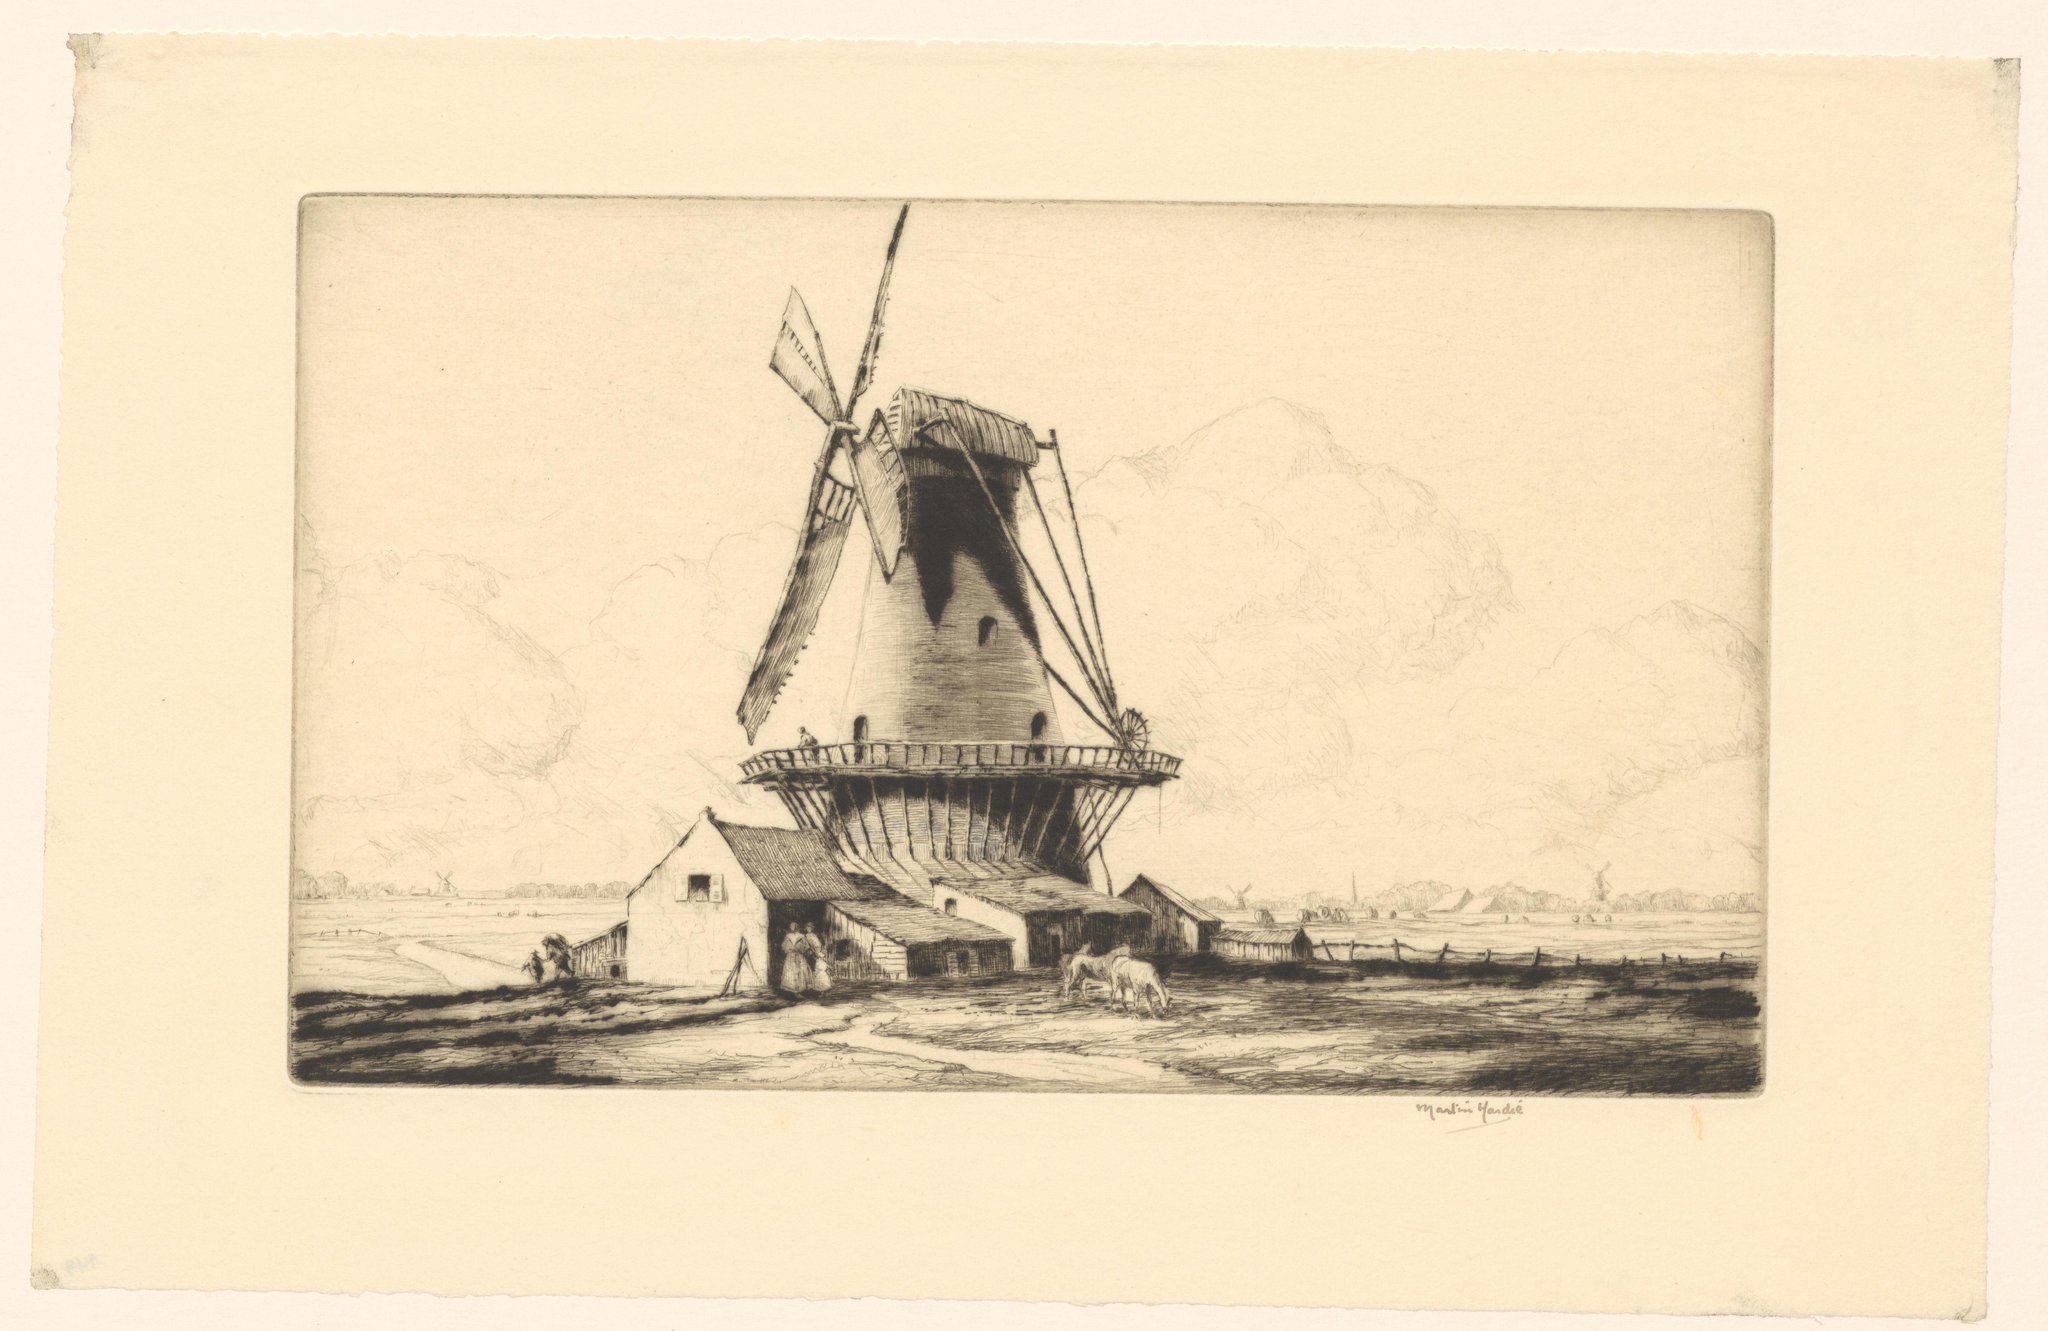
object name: print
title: Molen bij Middelburg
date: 1931-1945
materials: paper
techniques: drypoint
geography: middelburg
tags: windmill, meadow, pasture (+ landscape with figures, staffage), middelburg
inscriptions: collector's mark: Lugt 2760, collector's mark: Lugt 2228, annotation: ‘Martin Hardie’